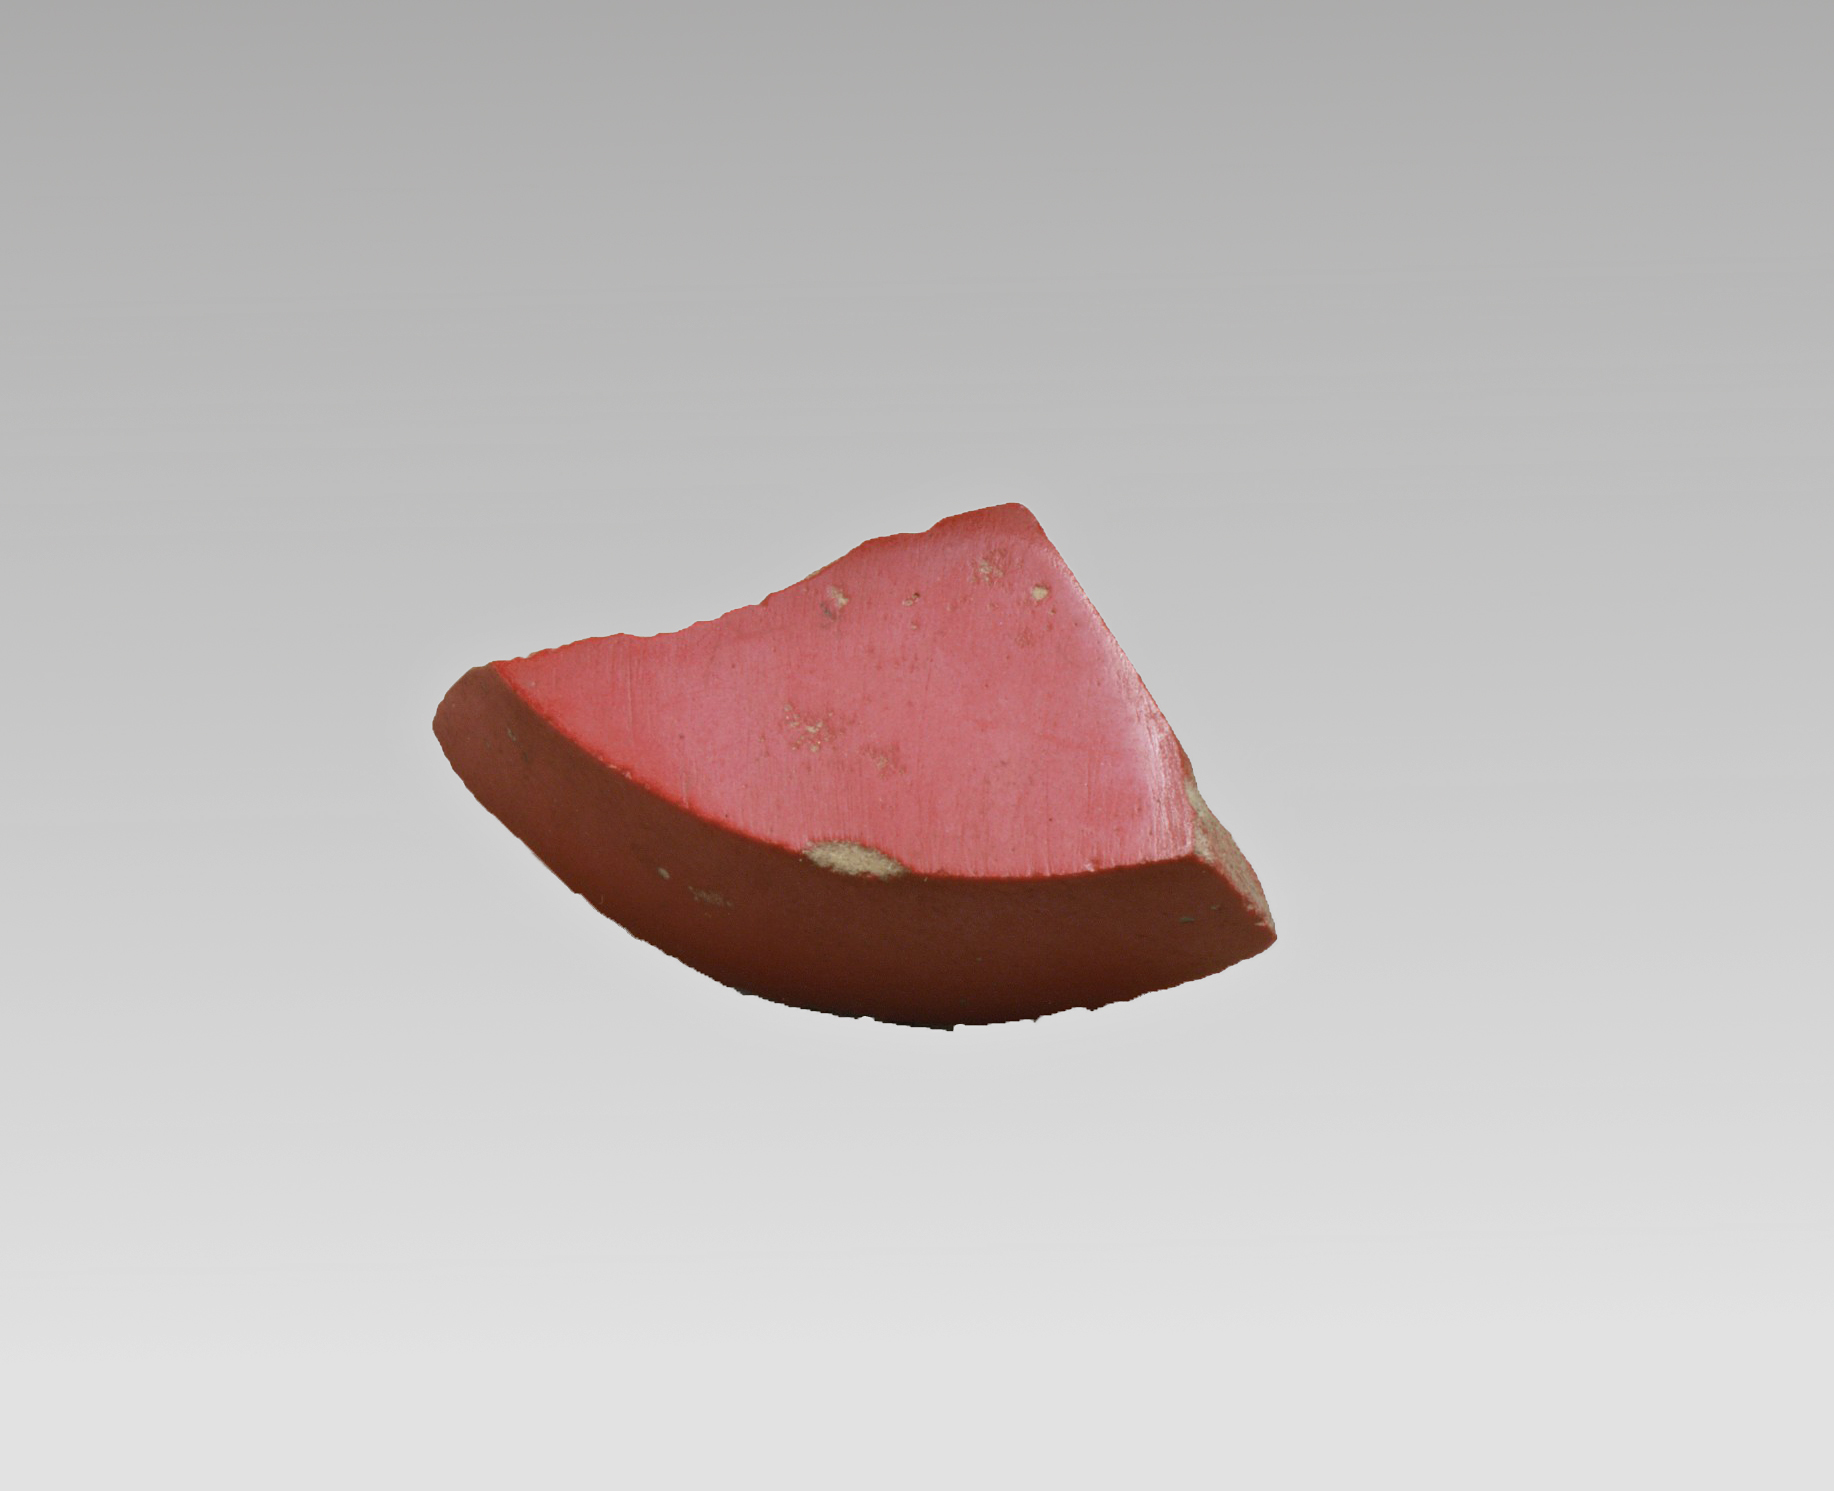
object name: fragment, monochrome, opaque red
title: Glass monochrome dish fragment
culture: roman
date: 1-50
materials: glass